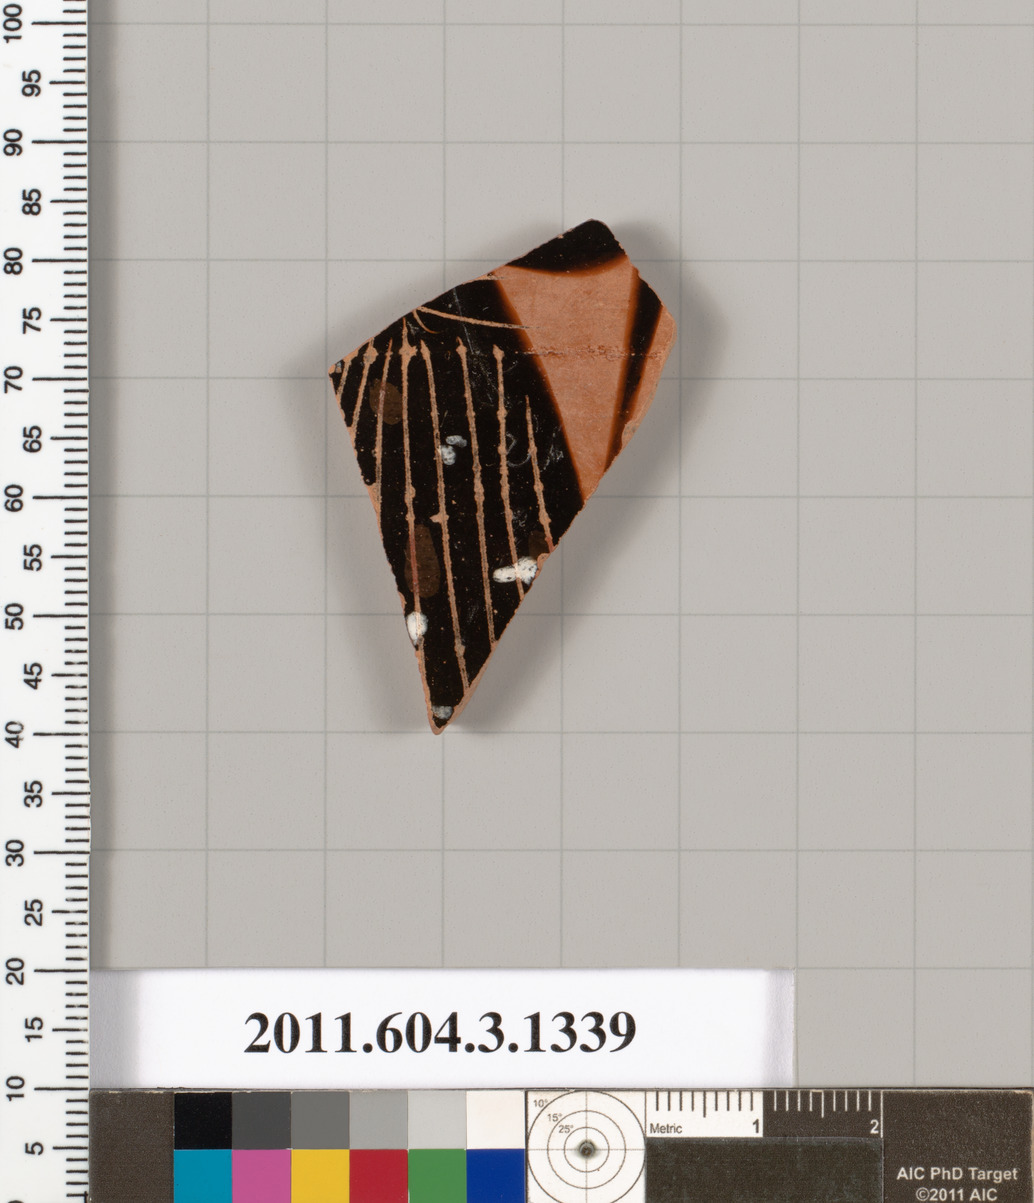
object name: skyphos fragment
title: Terracotta fragment of a skyphos (deep drinking cup)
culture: greek, attic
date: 500-468 BCE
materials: terracotta